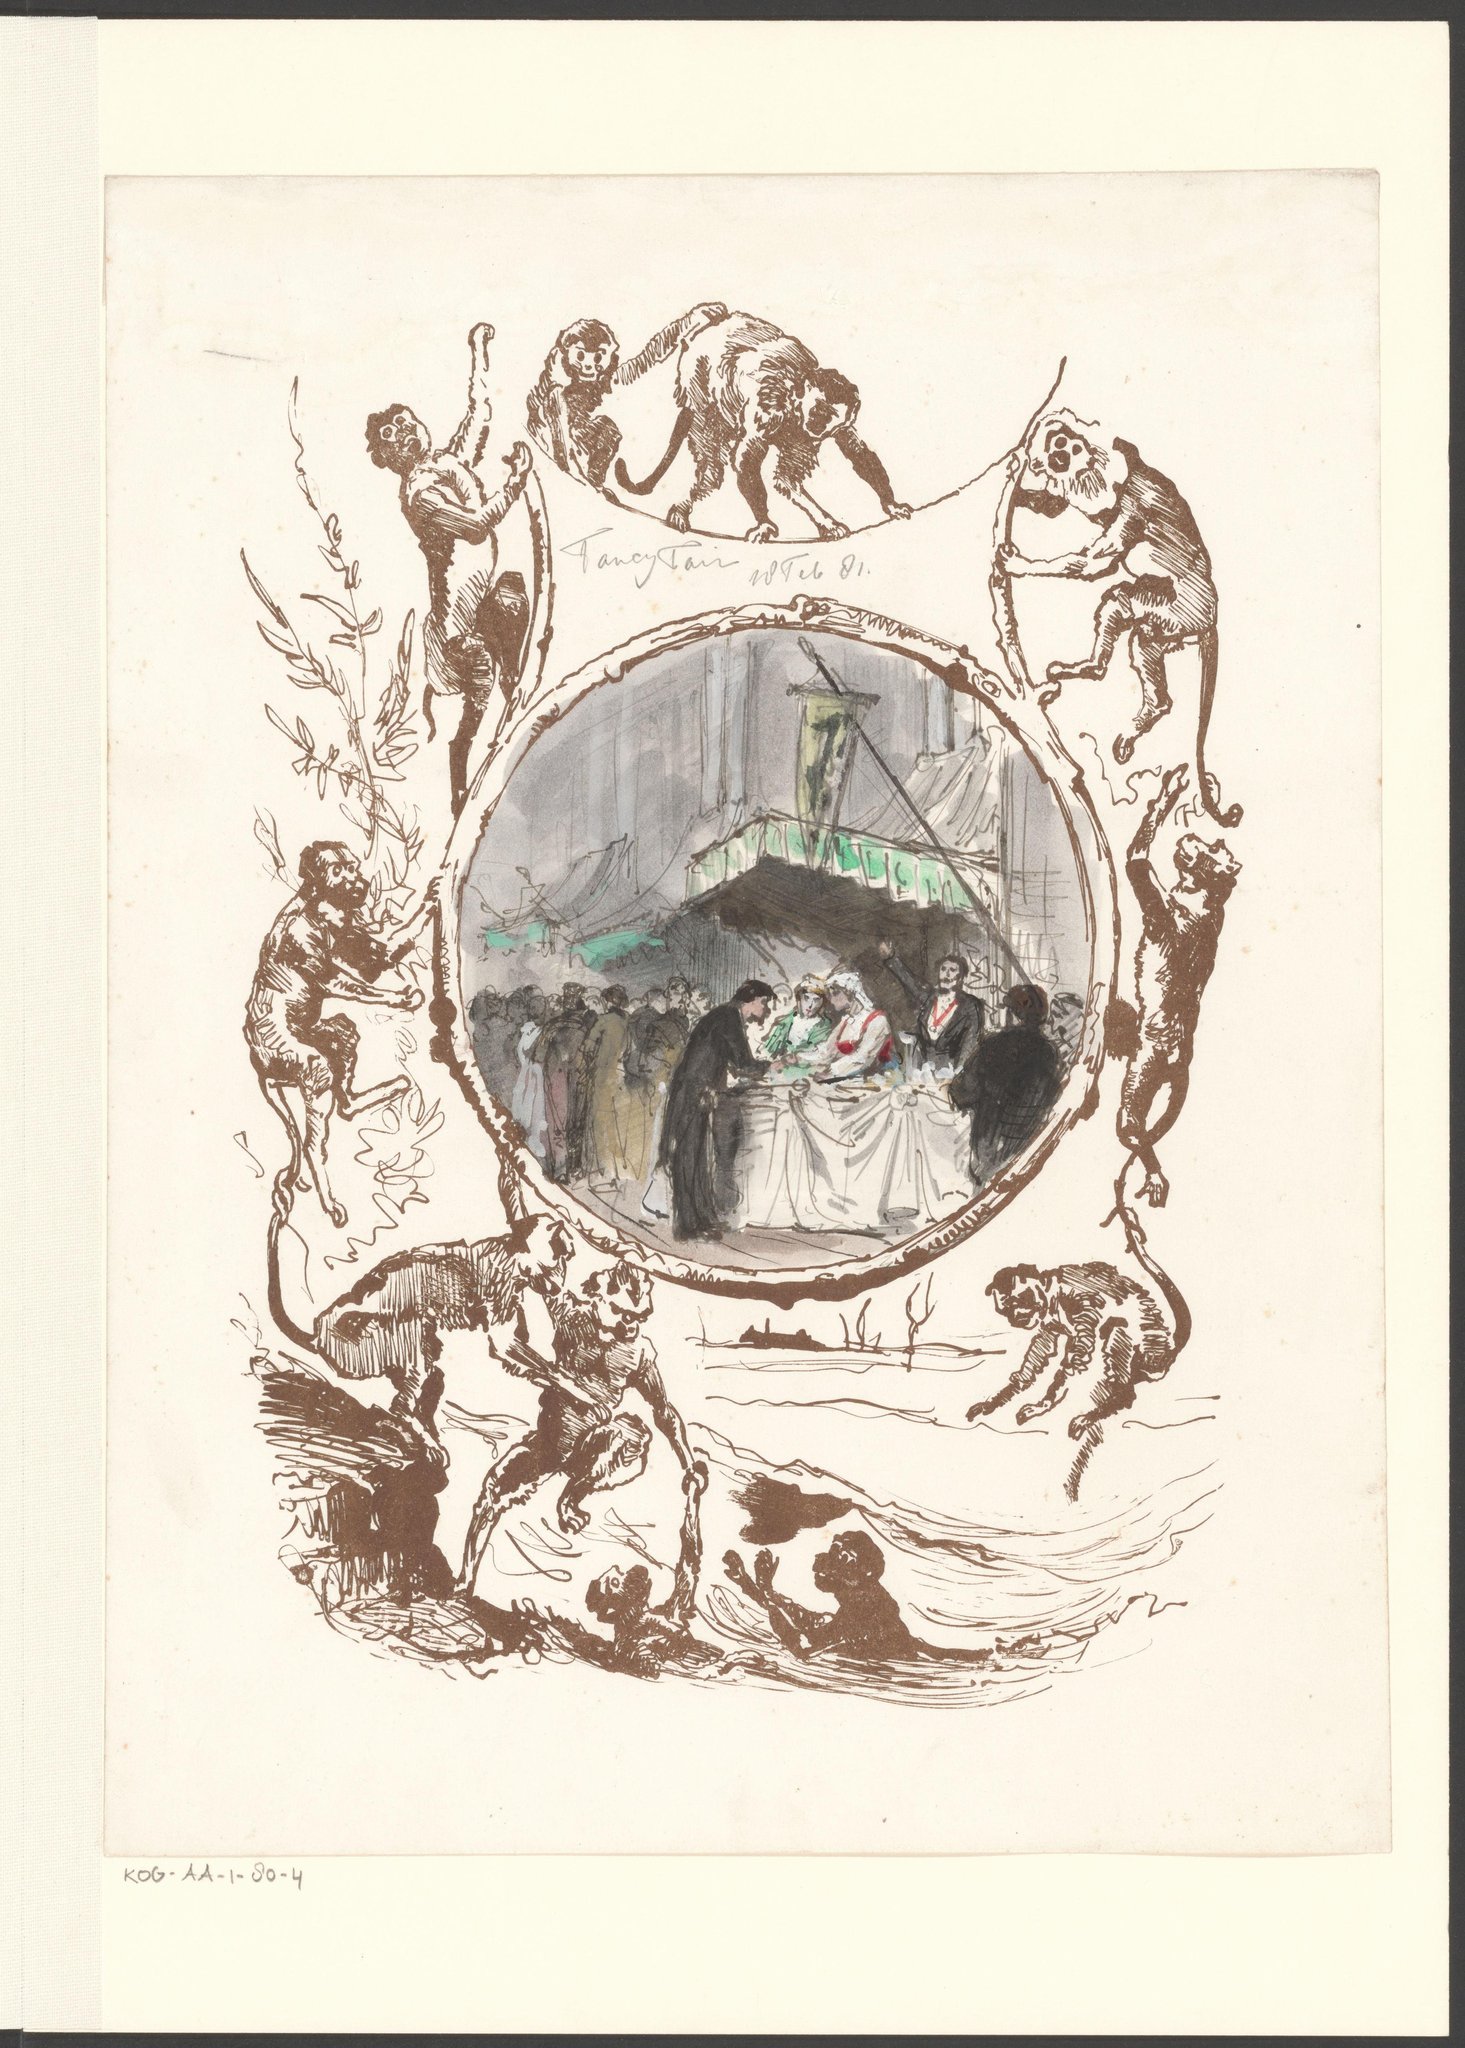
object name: print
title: Stands op de fancy-fair in het Paleis voor Volksvlijt ten bate van de slachtoffers van de watersnood van 18 februari 1881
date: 1881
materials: gouache, paper, pencil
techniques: brush, lithograph, pen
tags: flood, poster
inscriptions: date: ‘FancyFair 18 Feb 81.’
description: Onderwerpsrubriek binnen de Atlas Amsterdam: 1881-1886.